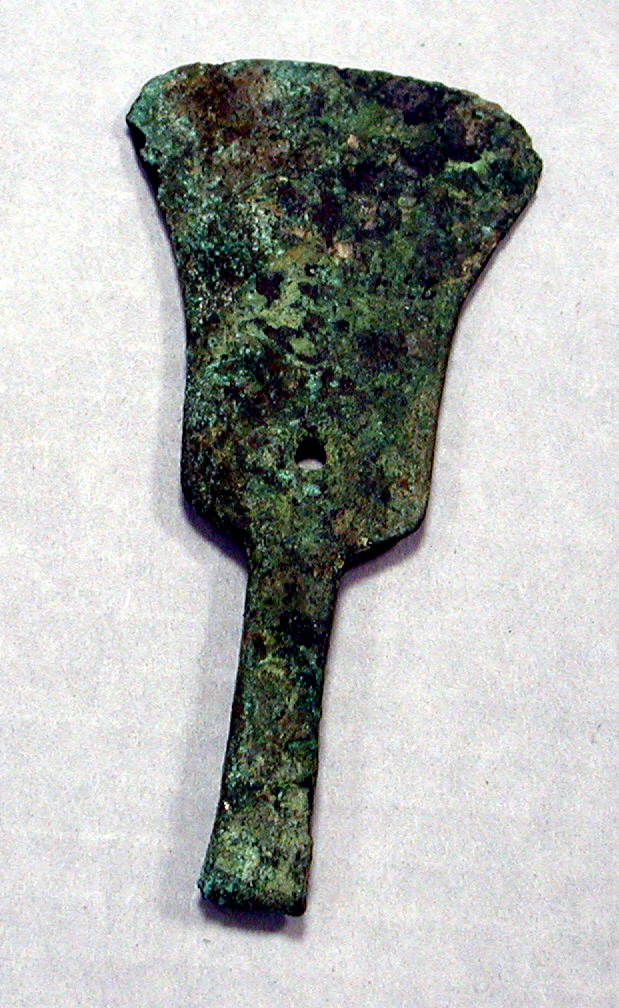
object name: knife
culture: moche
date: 1-766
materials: copper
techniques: hammering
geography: peru